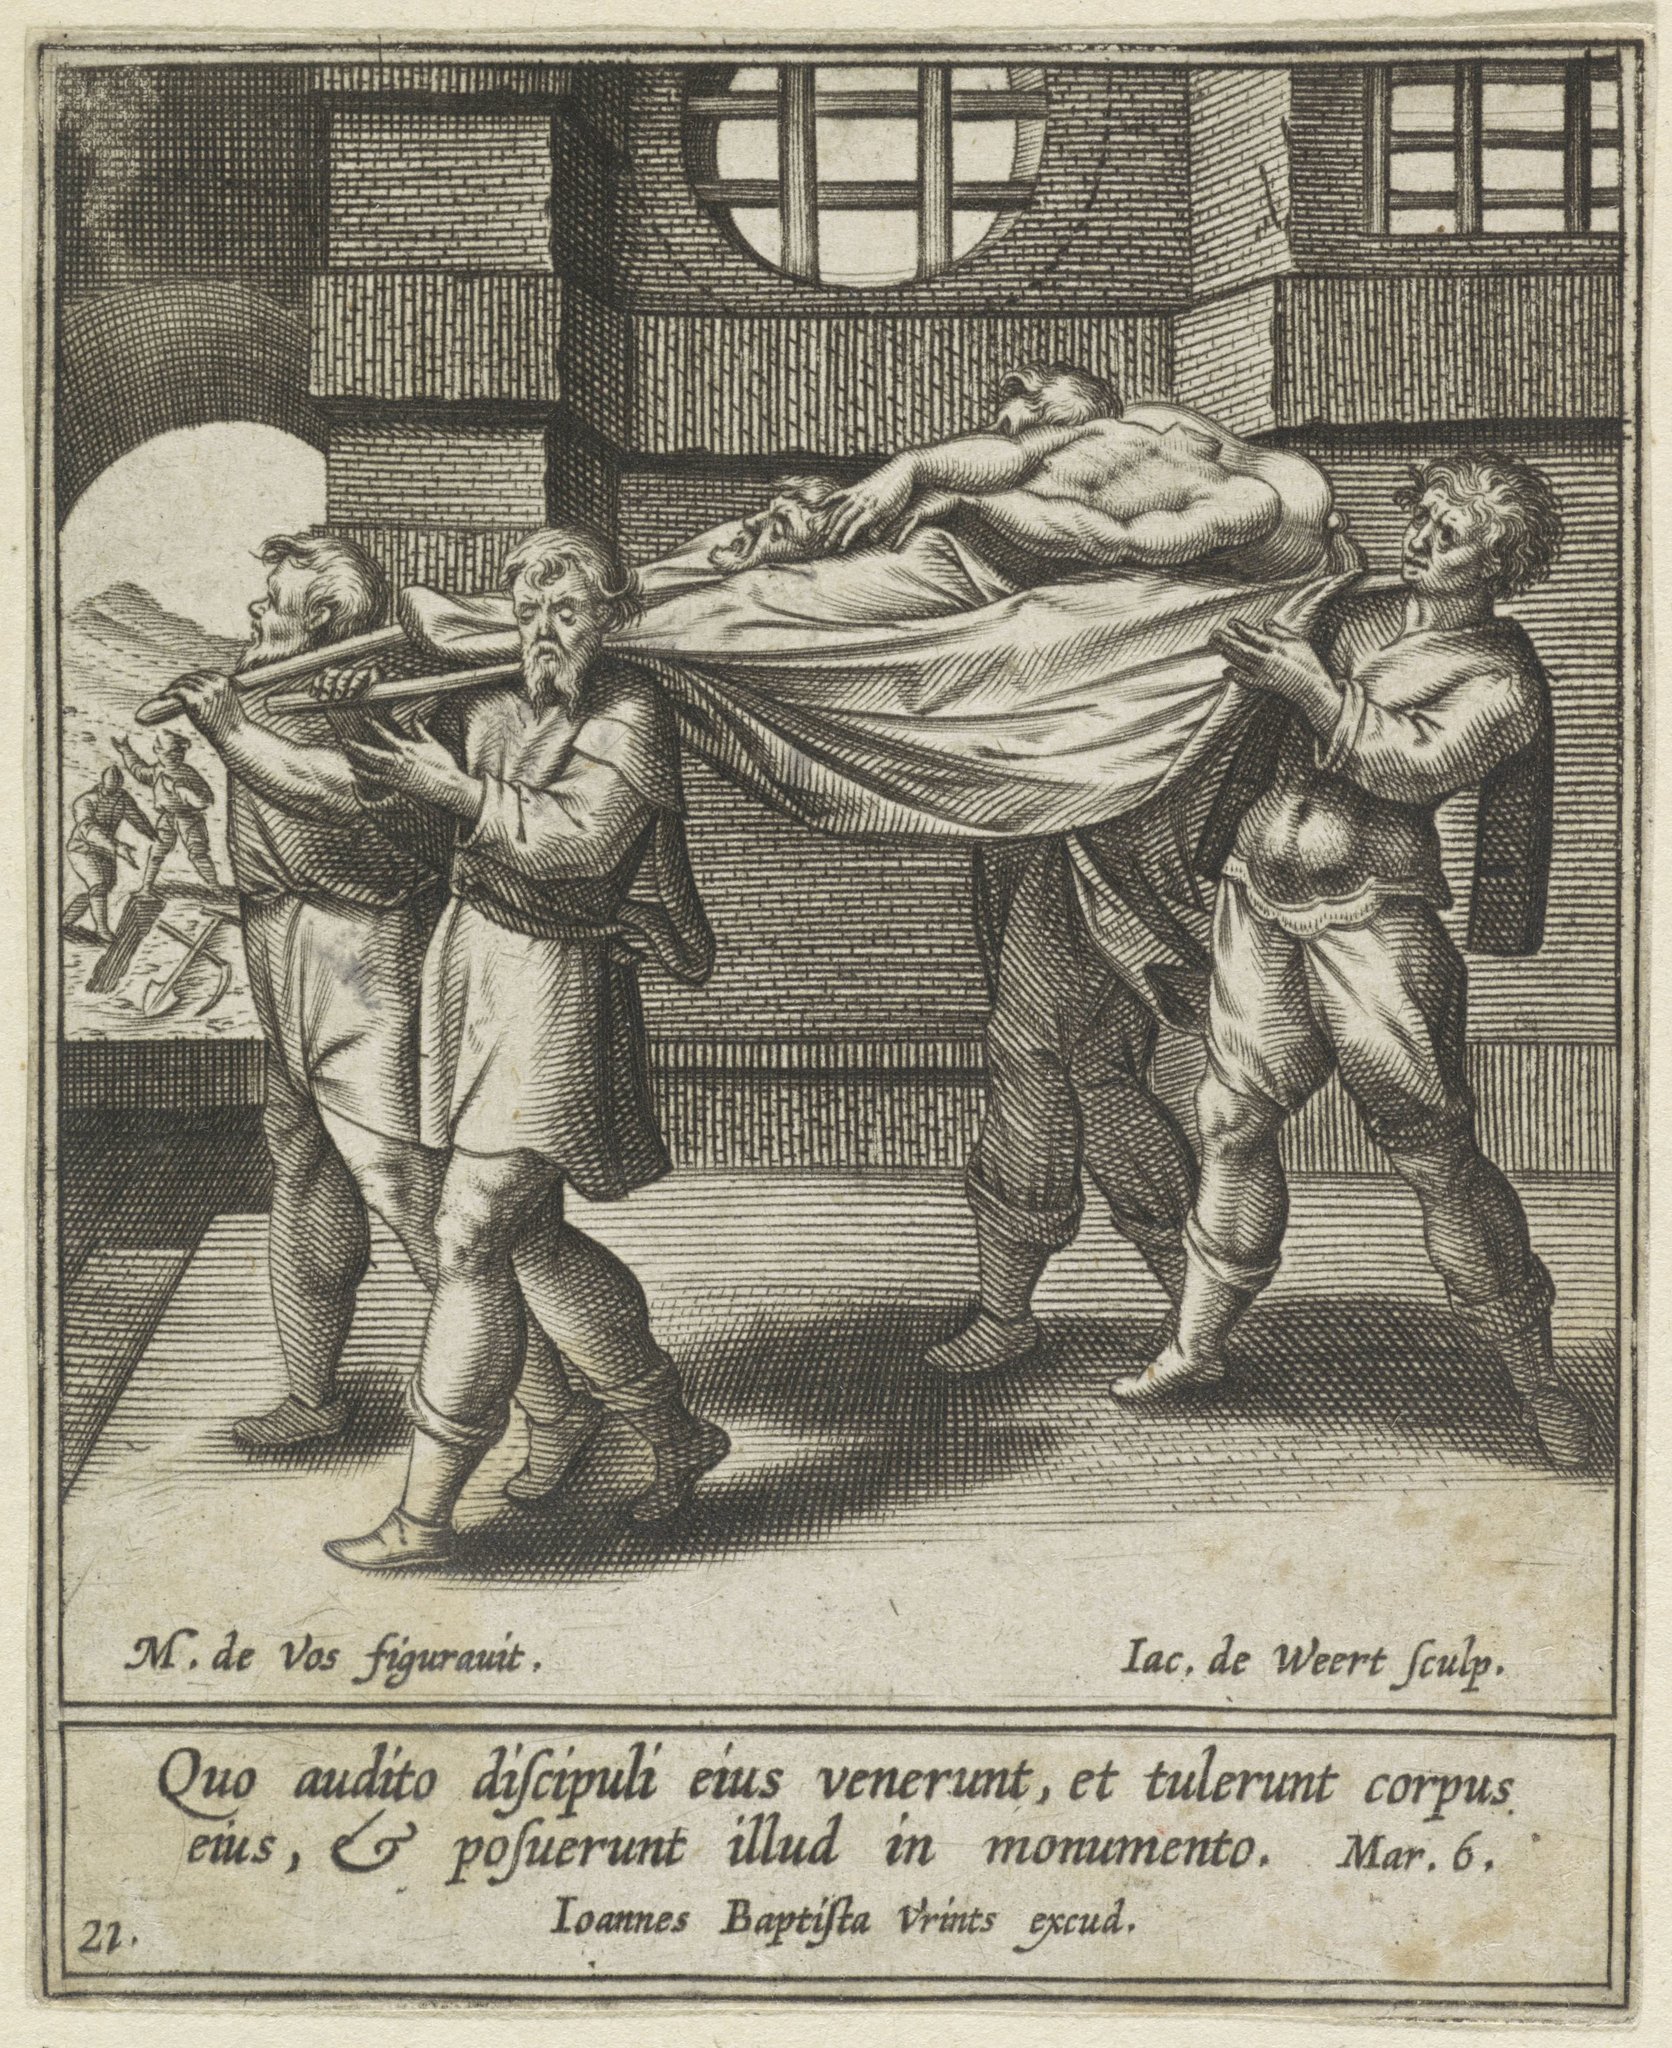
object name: print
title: Begrafenis van Johannes de Doper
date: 1580-1600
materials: paper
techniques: engraving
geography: antwerp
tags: lamentation and burial of john the baptist, (carrying a person on a) litter, stretcher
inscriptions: collector's mark: Lugt 240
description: Vier discipelen van Johannes de Doper dragen een brancard met zijn lichaam door de gevangenis. In de verte graven twee figuren buiten een graf. Onder de voorstelling bevindt zich een tweeregelige, Latijnse tekst met de beschrijving van de scène uit Mar. 6.